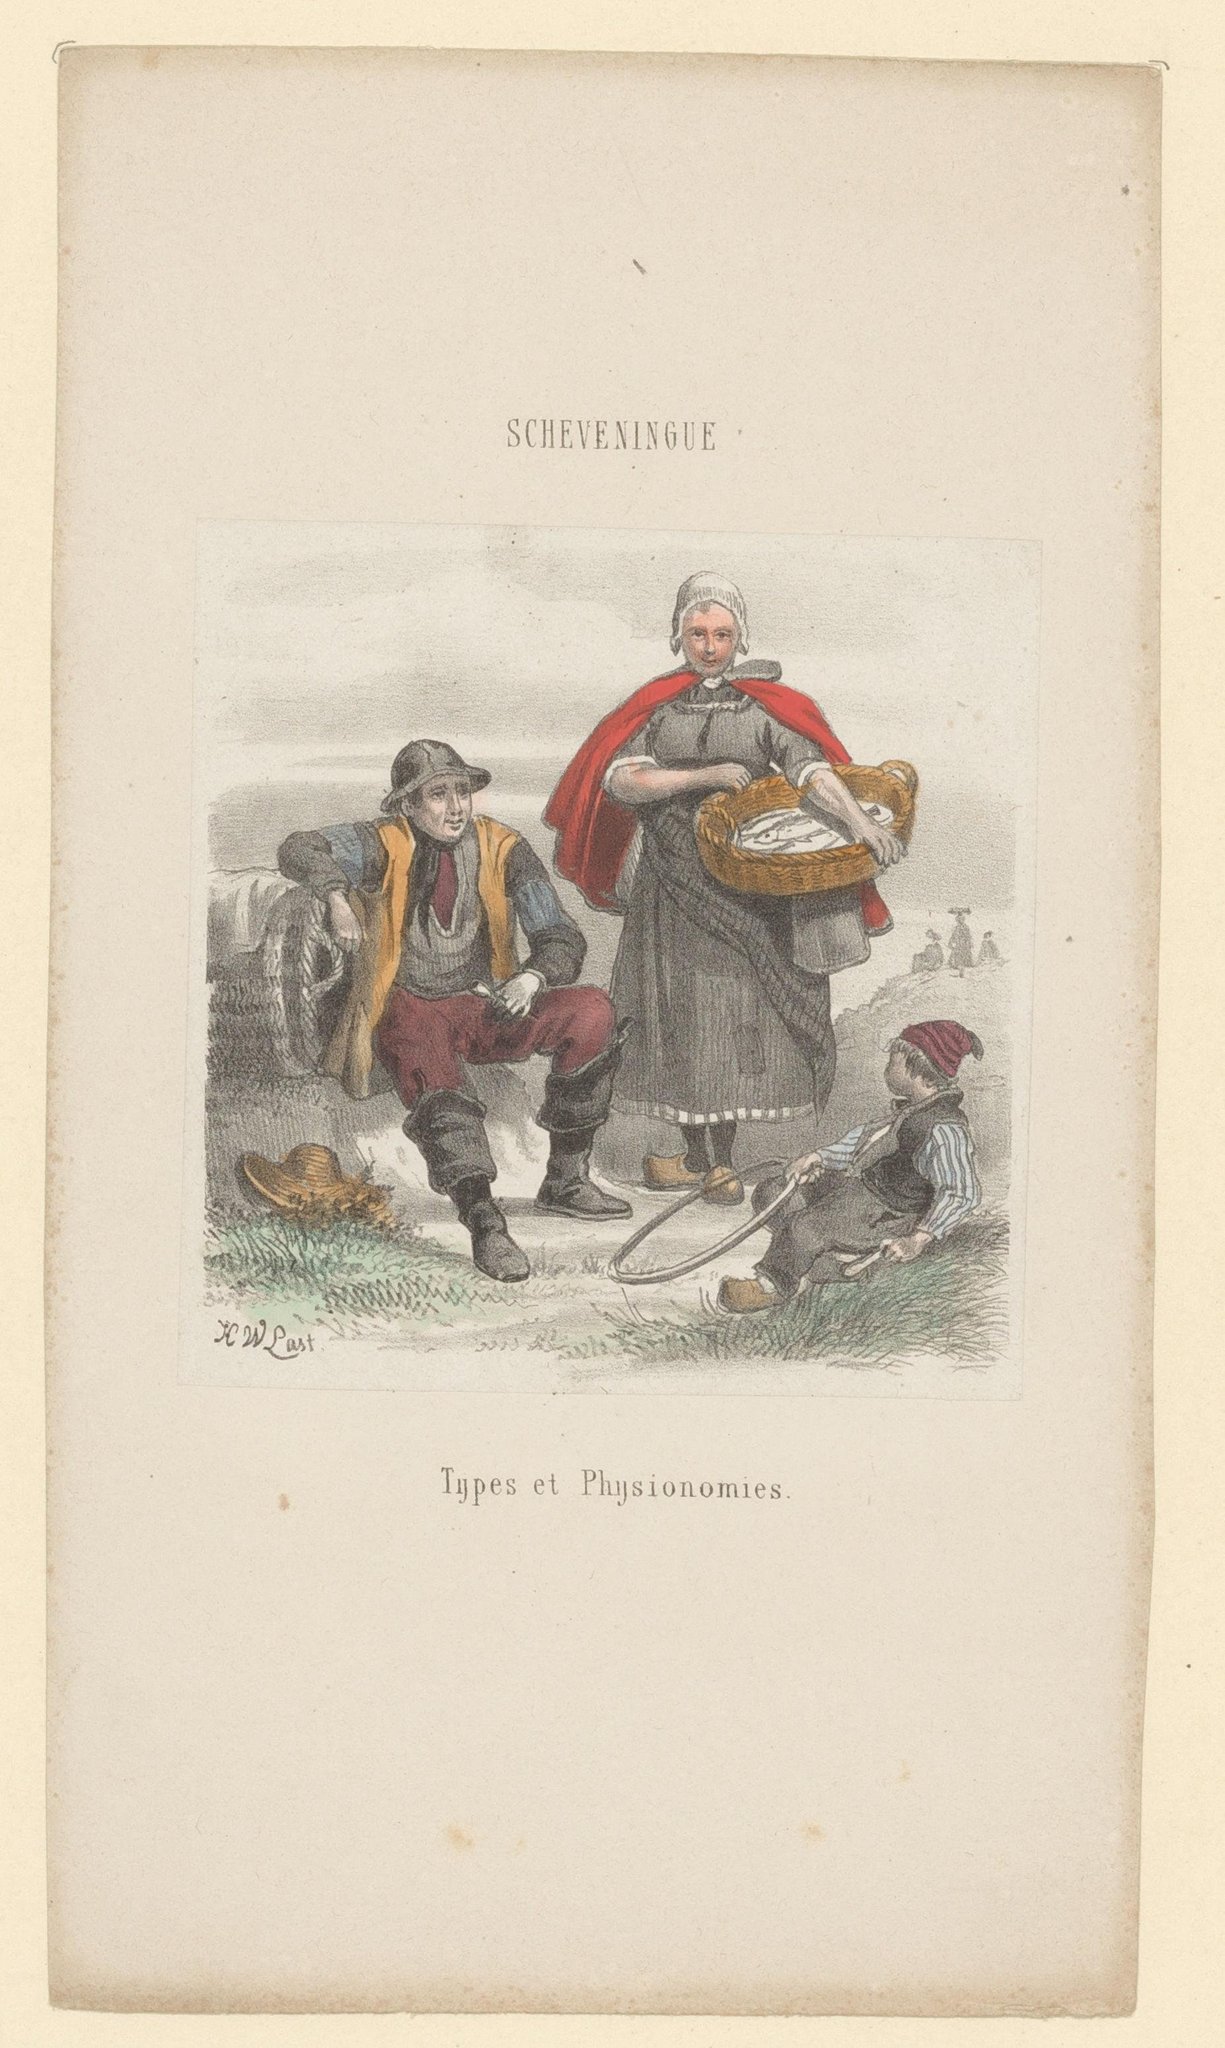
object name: print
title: Scheveningue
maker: hendrik wilhelmus last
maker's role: print maker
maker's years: 1817-1873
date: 1856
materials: watercolor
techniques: hand coloring, lithograph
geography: netherlands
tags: sea and coastal fishery (+ men (labourers)), family group, especially parents with their child(ren), sea and coastal fishery (+ women (labourers)), clothes, costume (+ women's clothes), clothes, costume (+ men's clothes), folk costume, regional costume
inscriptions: collector's mark: Lugt 1641, collector's mark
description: Gebruikt als illustratie: Souvenir de Schéveningue. Dessiné d'après nature par H. W. Last. [Herinnering aan Scheveningen]. Uitgegeven door M. J. Visser, La Haye, 1856.